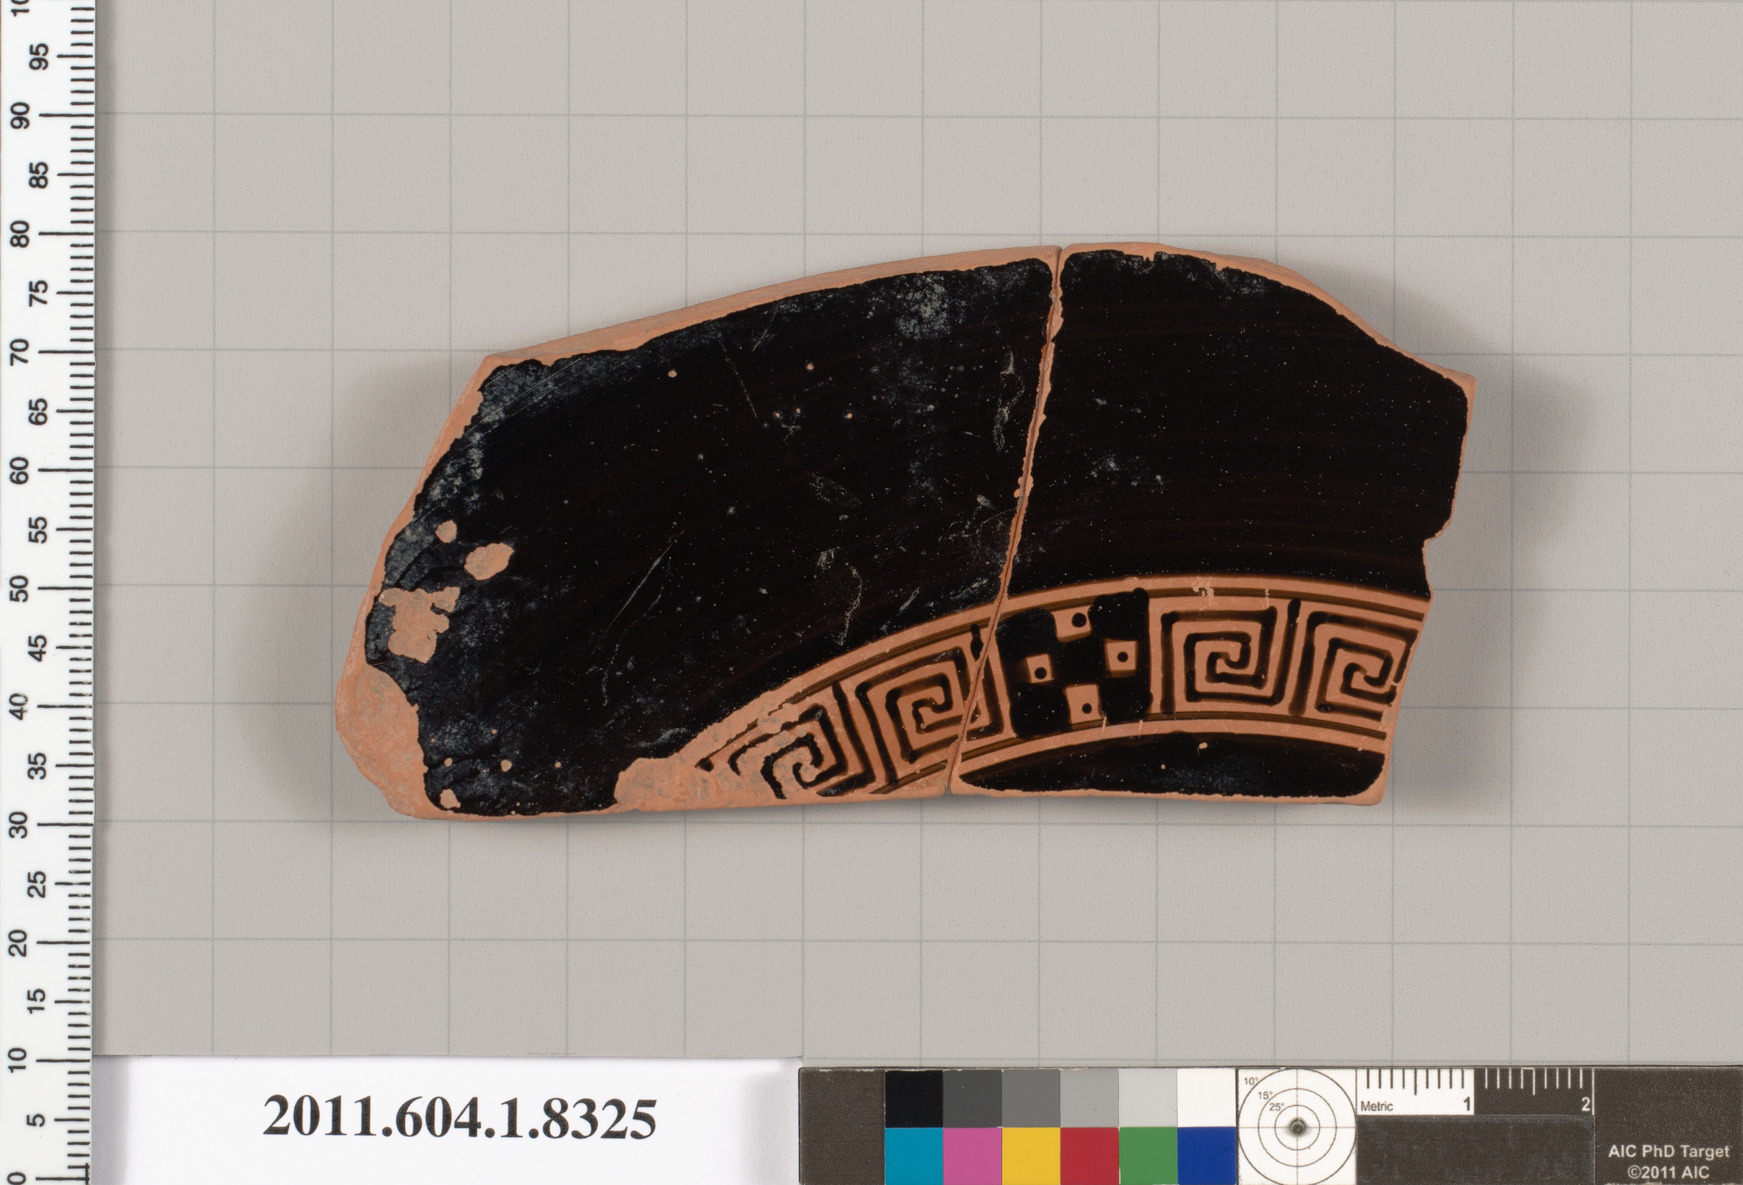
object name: kylix fragment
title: Terracotta fragment of a kylix (drinking cup)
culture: greek, attic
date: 450-426 BCE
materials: terracotta